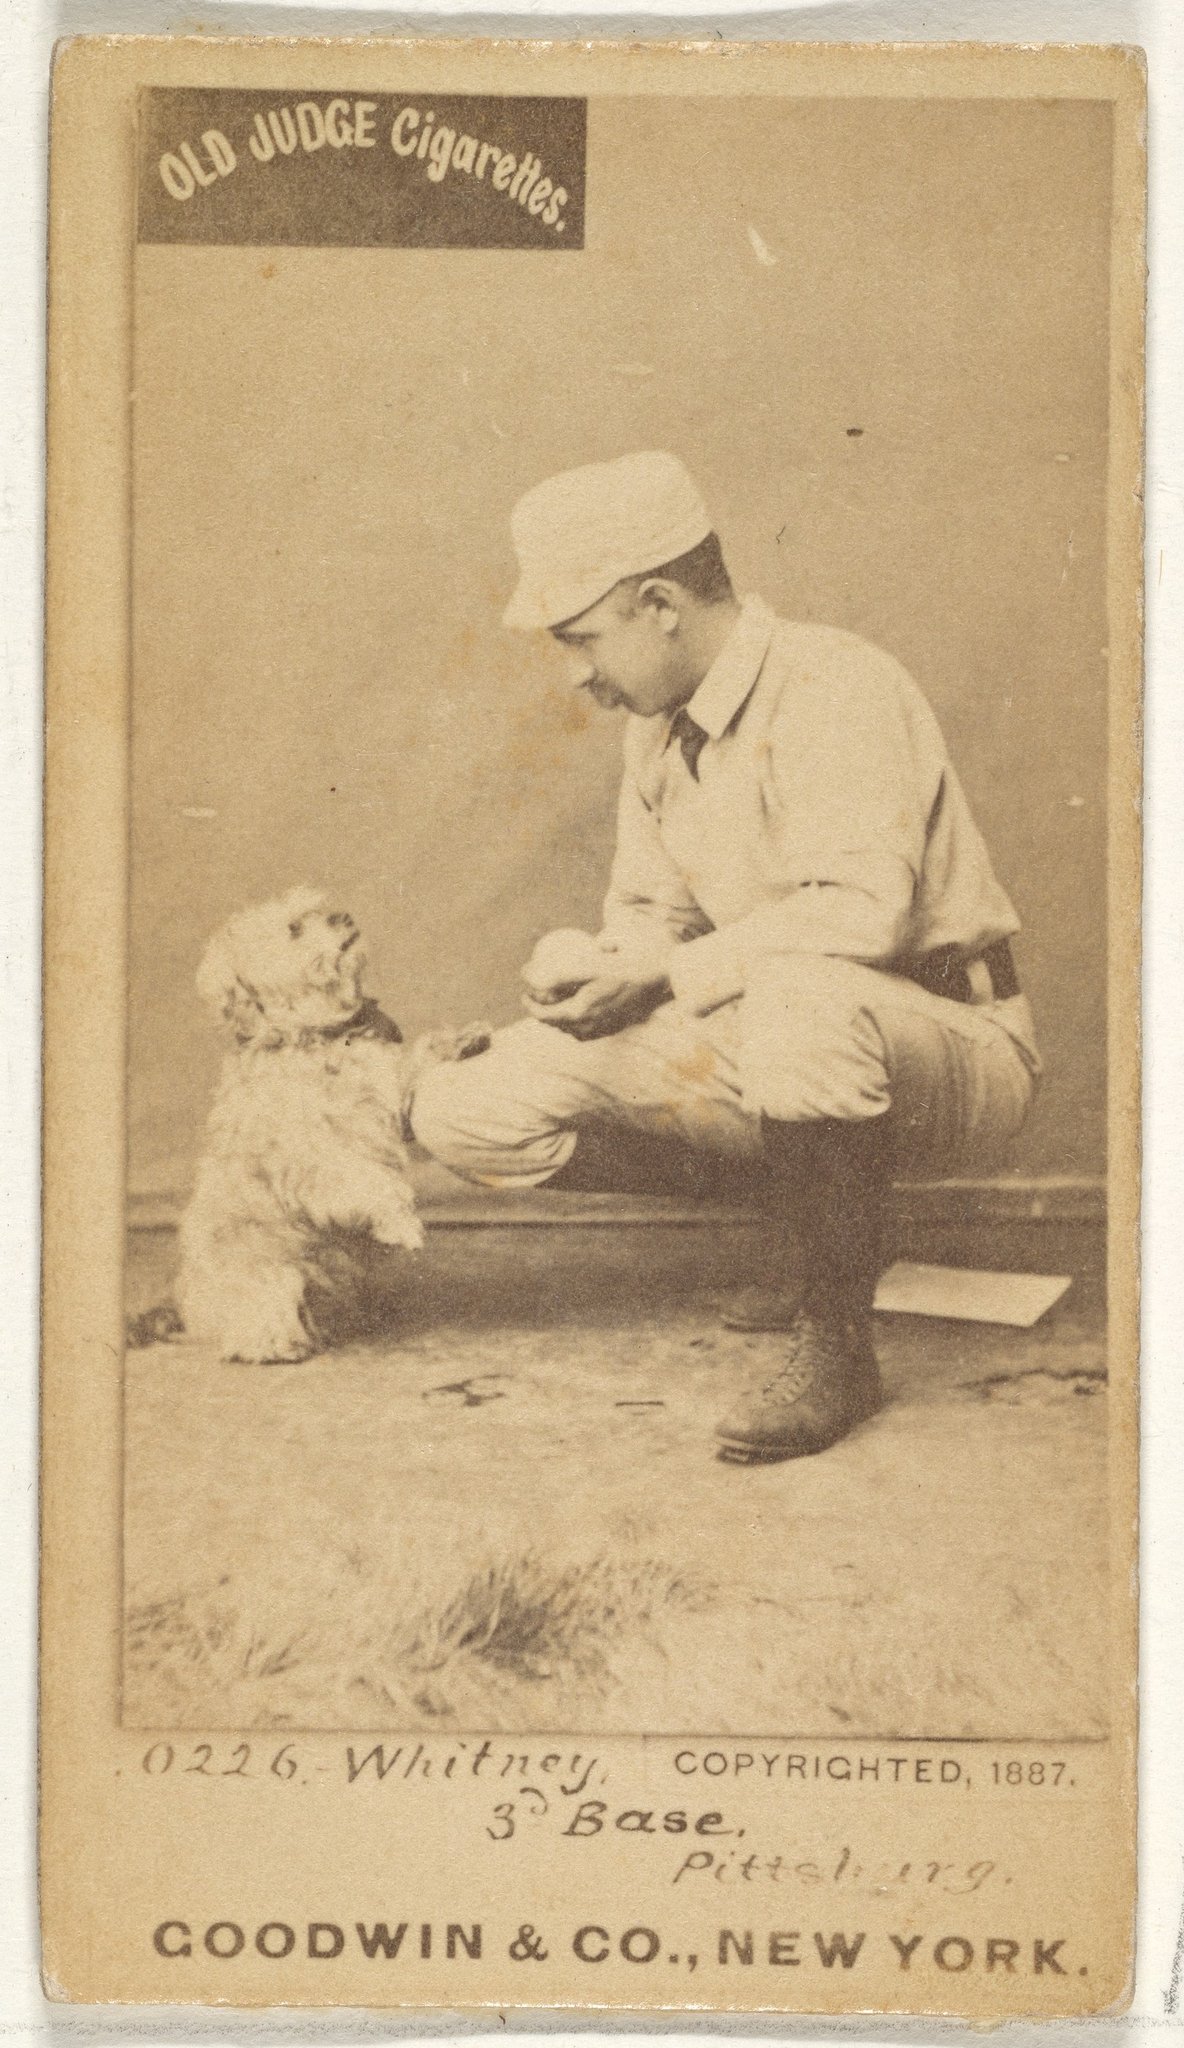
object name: baseball card, photograph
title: Arthur "Art" Wilson Whitney, 3rd Base, Pittsburgh, from the Old Judge series (N172) for Old Judge Cigarettes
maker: goodwin & company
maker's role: publisher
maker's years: 1850-1950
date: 1887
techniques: albumen silver print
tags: men,dogs,athletes